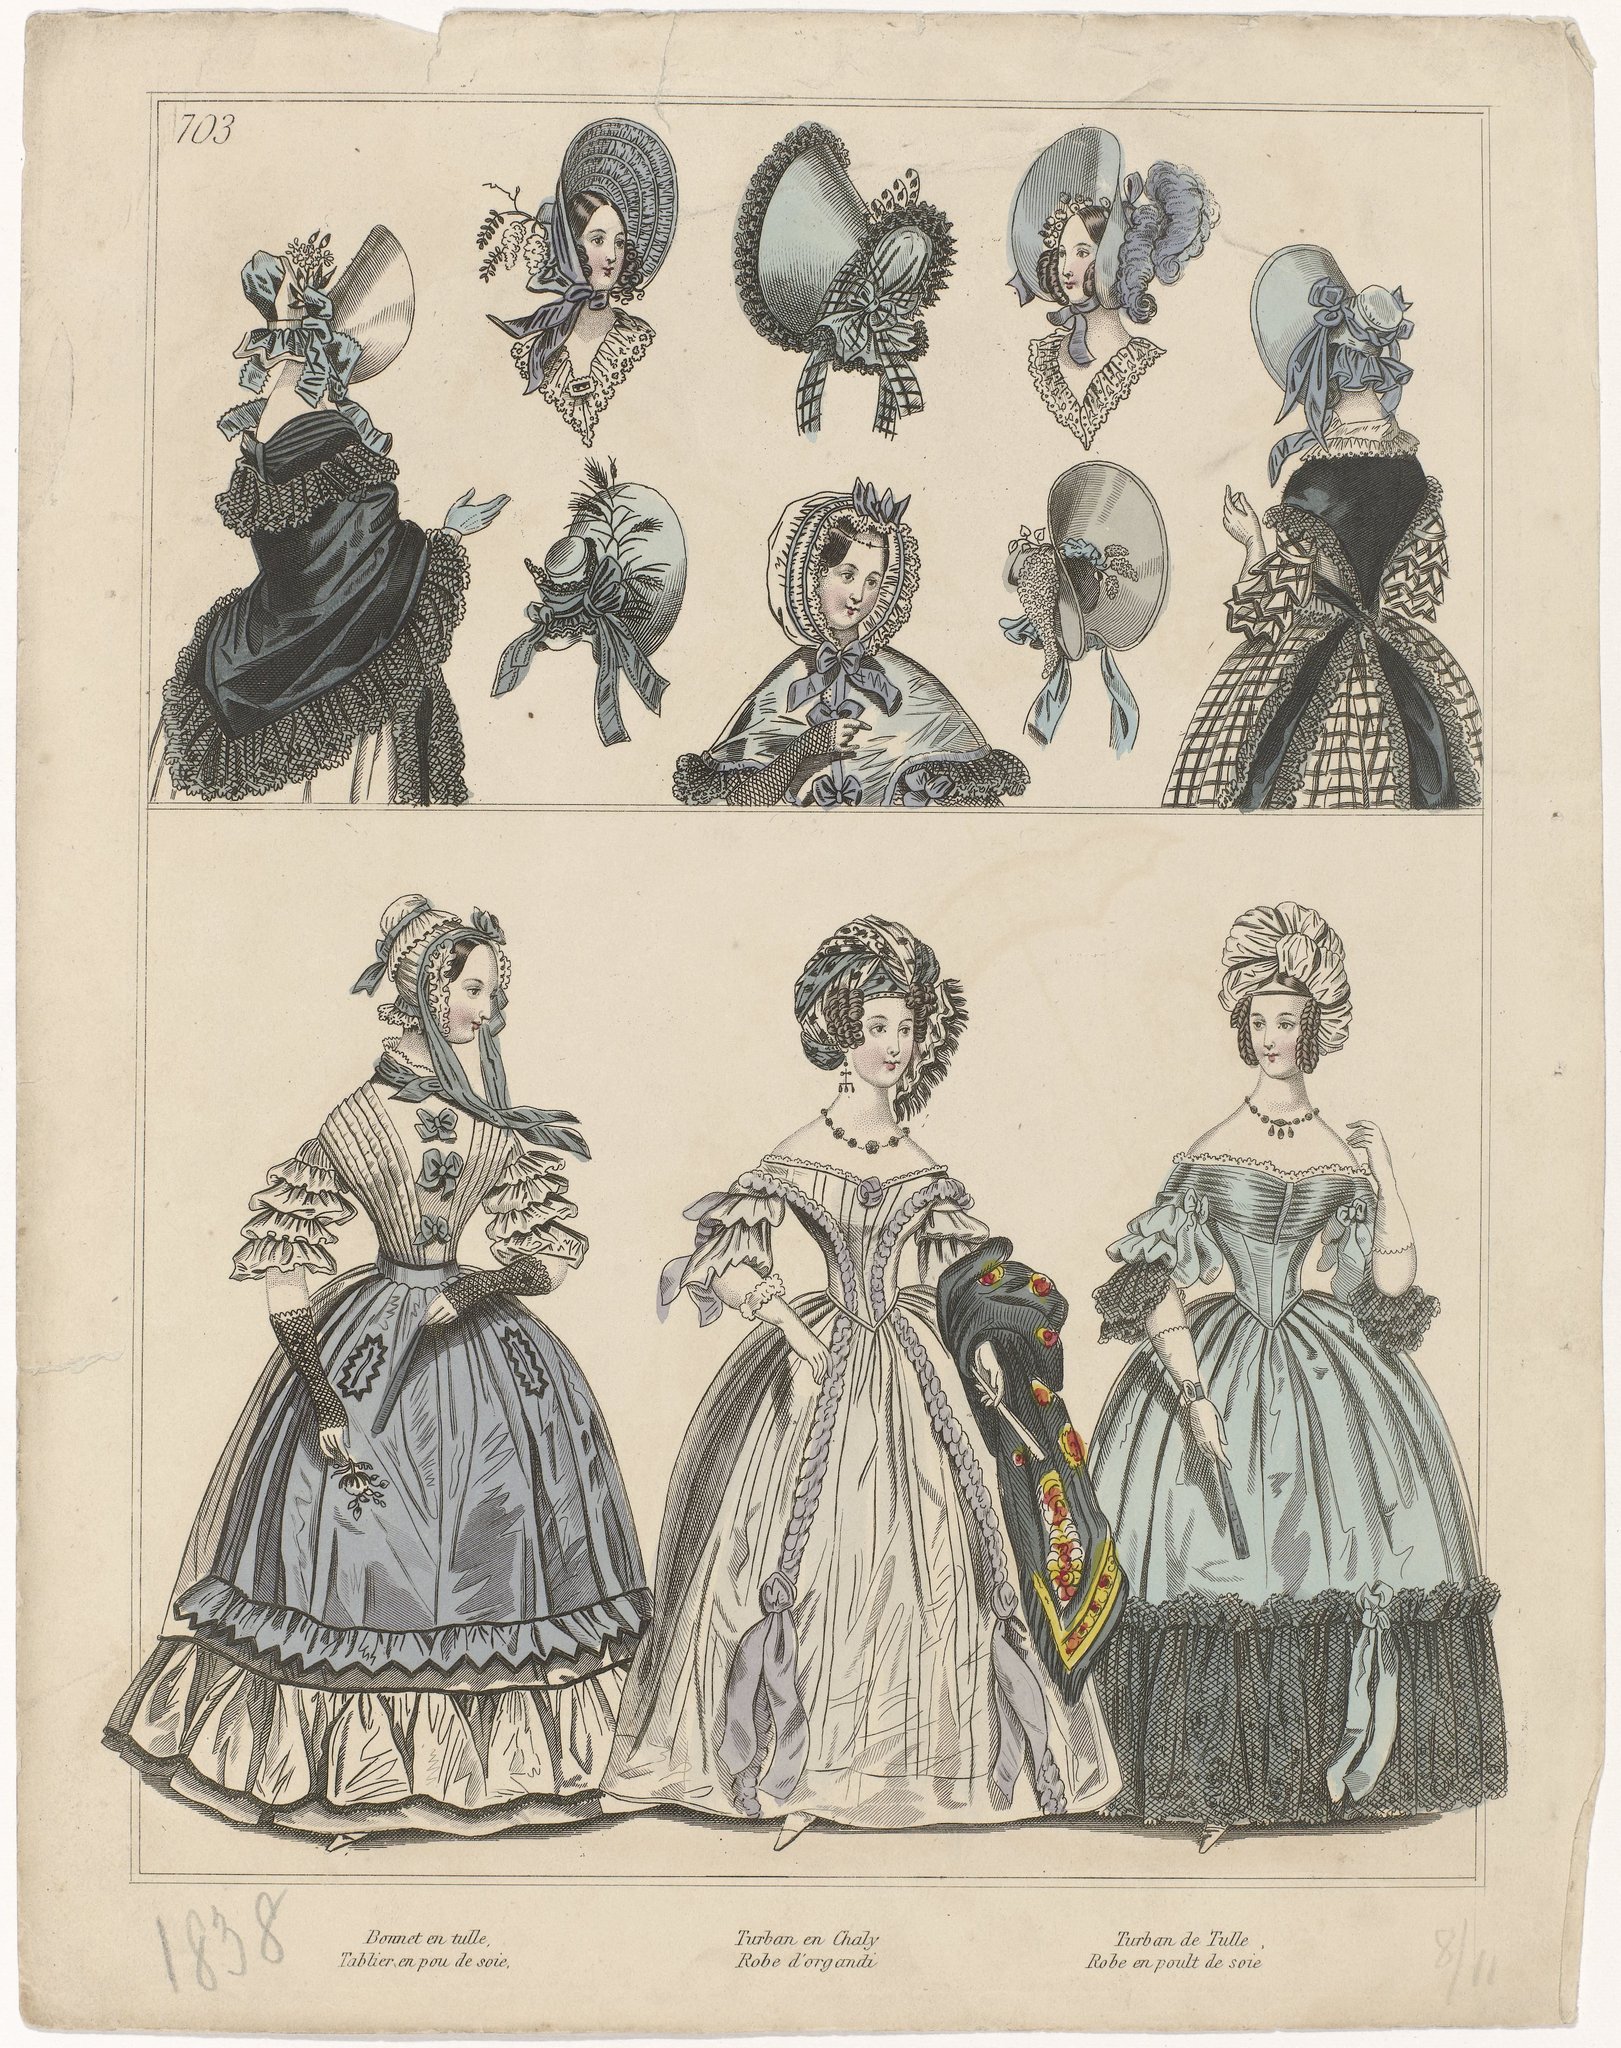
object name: fashion print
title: Townsend's Monthly Selection of Parisian Costumes, 1838, No. 703 : Bonnet en tull (...)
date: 1838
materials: paper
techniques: engraving, hand coloring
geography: london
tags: head-gear: turban (+ women's clothes), gloves, mittens (mitaines) (+ women's clothes), head-gear: cap (+ women's clothes), fashion plates, head-gear: hat (+ women's clothes), dress, gown (+ women's clothes), apron (+ women's clothes)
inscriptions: caption: ‘Bonnet en tulle, Tablier en pou de soie. / Turban en Chaly Robe d'organdi / Turban de Tulle. Robe en poult de soie’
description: In het bovenste kader zeven verschillende luifelhoeden en een muts. In het onderste kader drie vrouwen, van links naar rechts: muts van tule en schort van 'pou de soie'. Mitaines. Tulband van 'chaly'. Japon van organdie. Tulband van tule. Japon van 'poult de soie'. Prent uit het modetijdschrift Townsends Monthly Selection of Parisian Costumes (London 1823-1888).